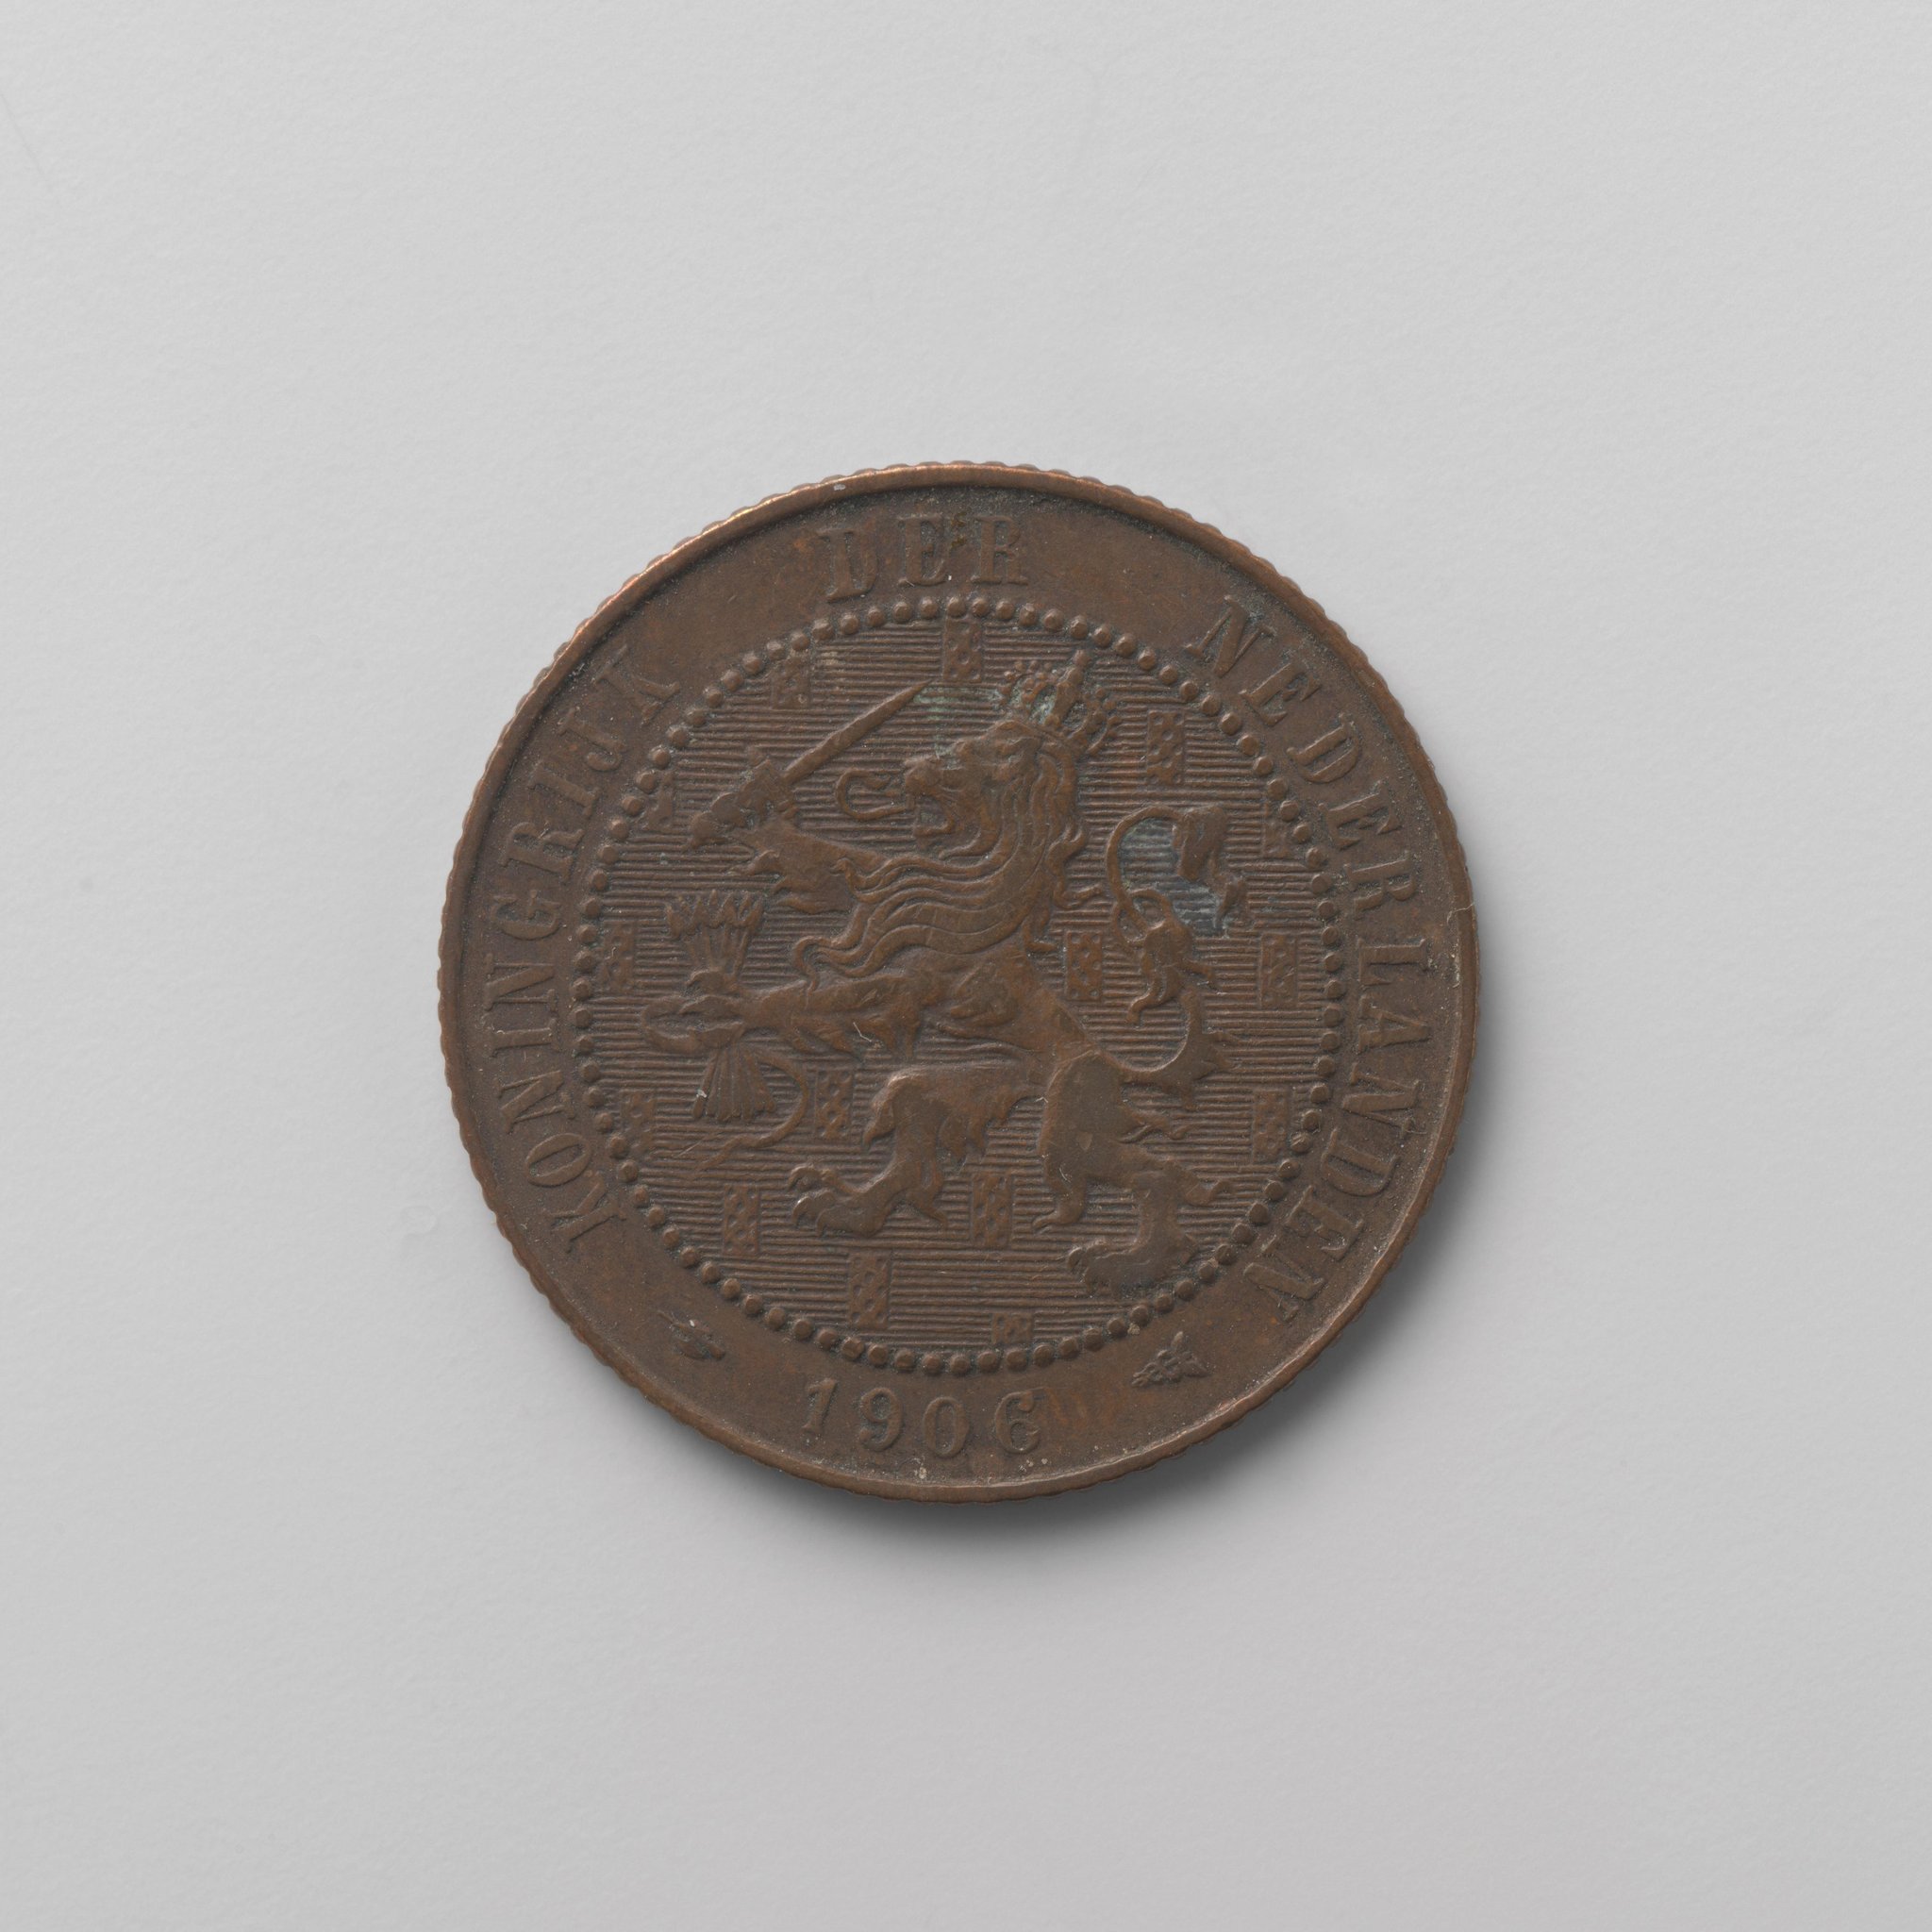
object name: twee en een halve cent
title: Nederlandse 2½ cent,1906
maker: wilhelmina of the netherlands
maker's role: print maker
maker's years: 1880-1962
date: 1906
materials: bronze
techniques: striking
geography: utrecht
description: Bronzen munt. Voorzijde: in een veld rijkswapen. Jaartal onderaan in omschrift.Keerzijde: binnen twee samengebonden oranjetakken waarde-aanduiding 2½ cent. Kartelrand.